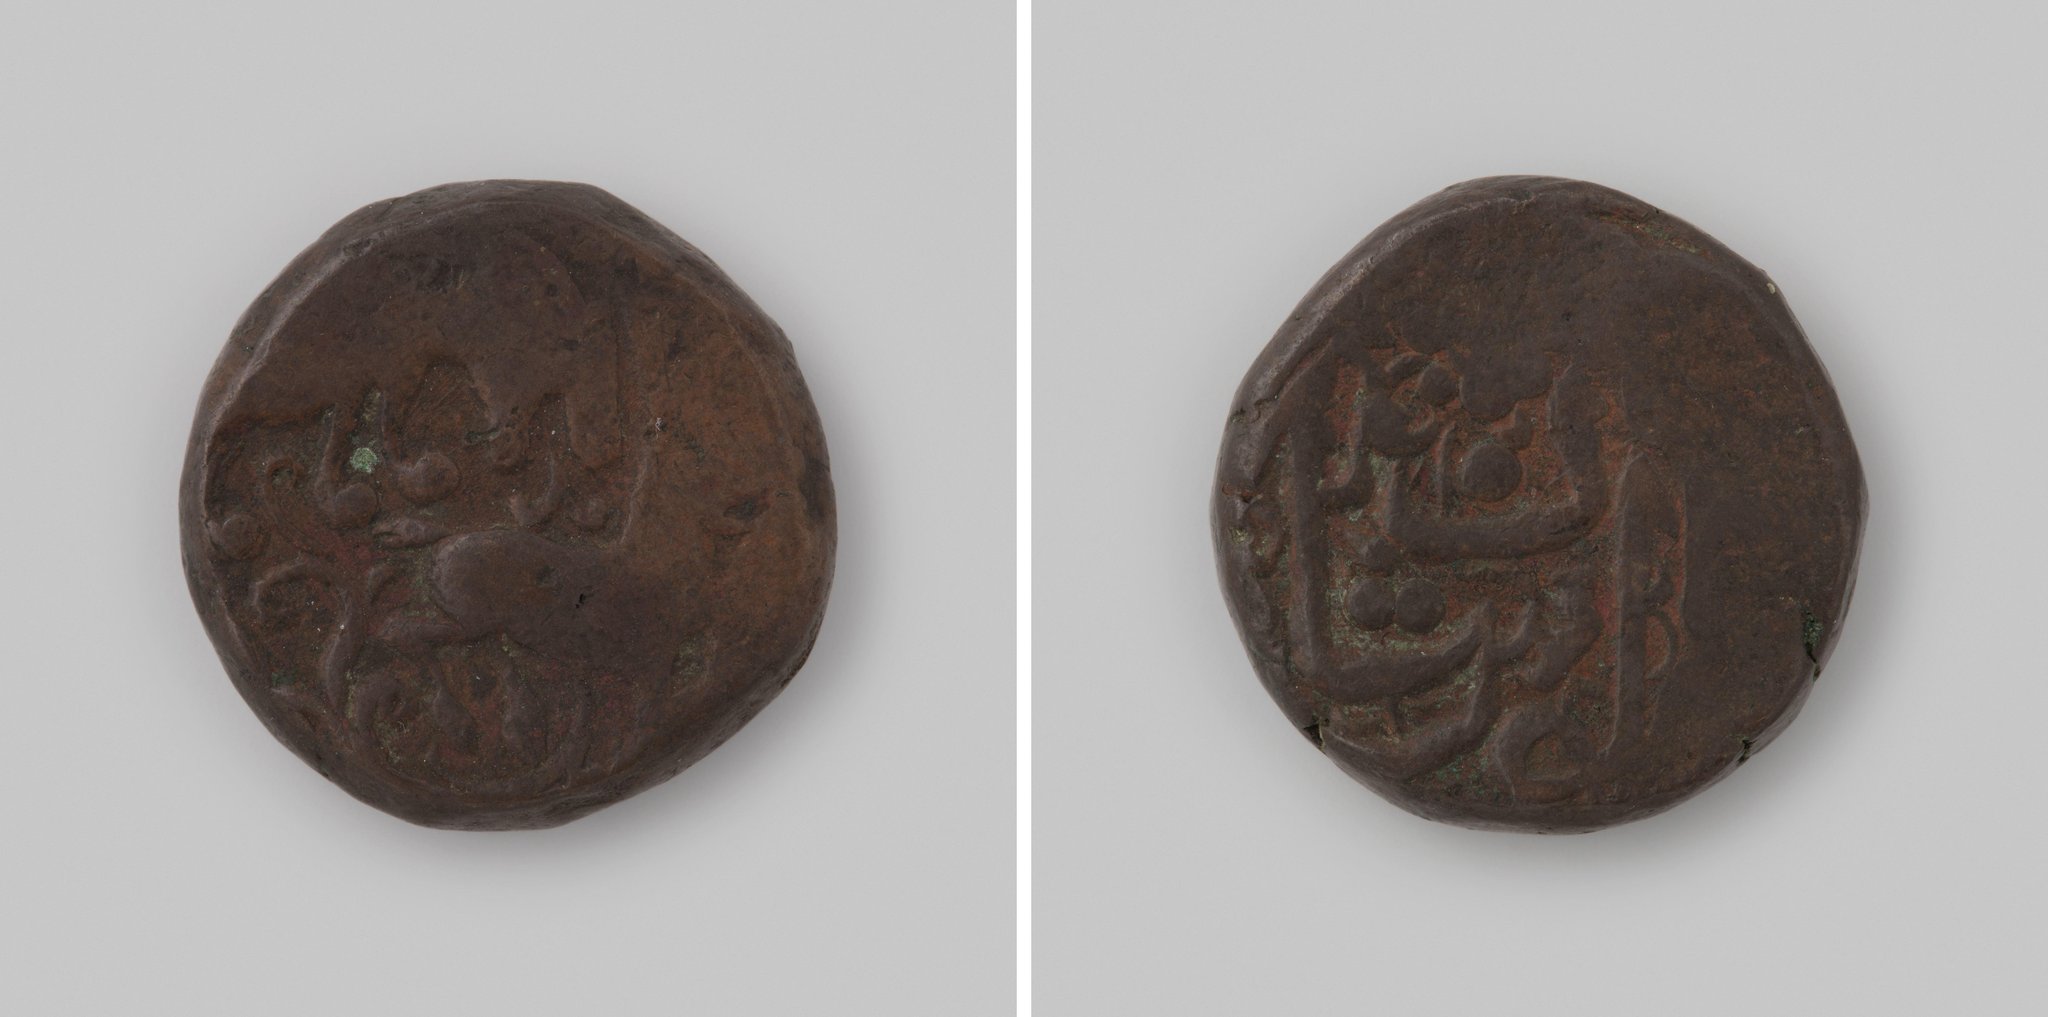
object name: coin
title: Perzië, ten tijde van Fateh Ali sjah, 1212-1250 [=1798-1835], dubbele falus, Isphahan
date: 1798-1835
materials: copper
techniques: striking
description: Koperen munt. Voorzijde: rund en paard naar rechts, waaromheen versiering. Keerzijde: in Arabische lettertekens in drie regels muntplaats-aanduiding. Geslagen te Isphahan.